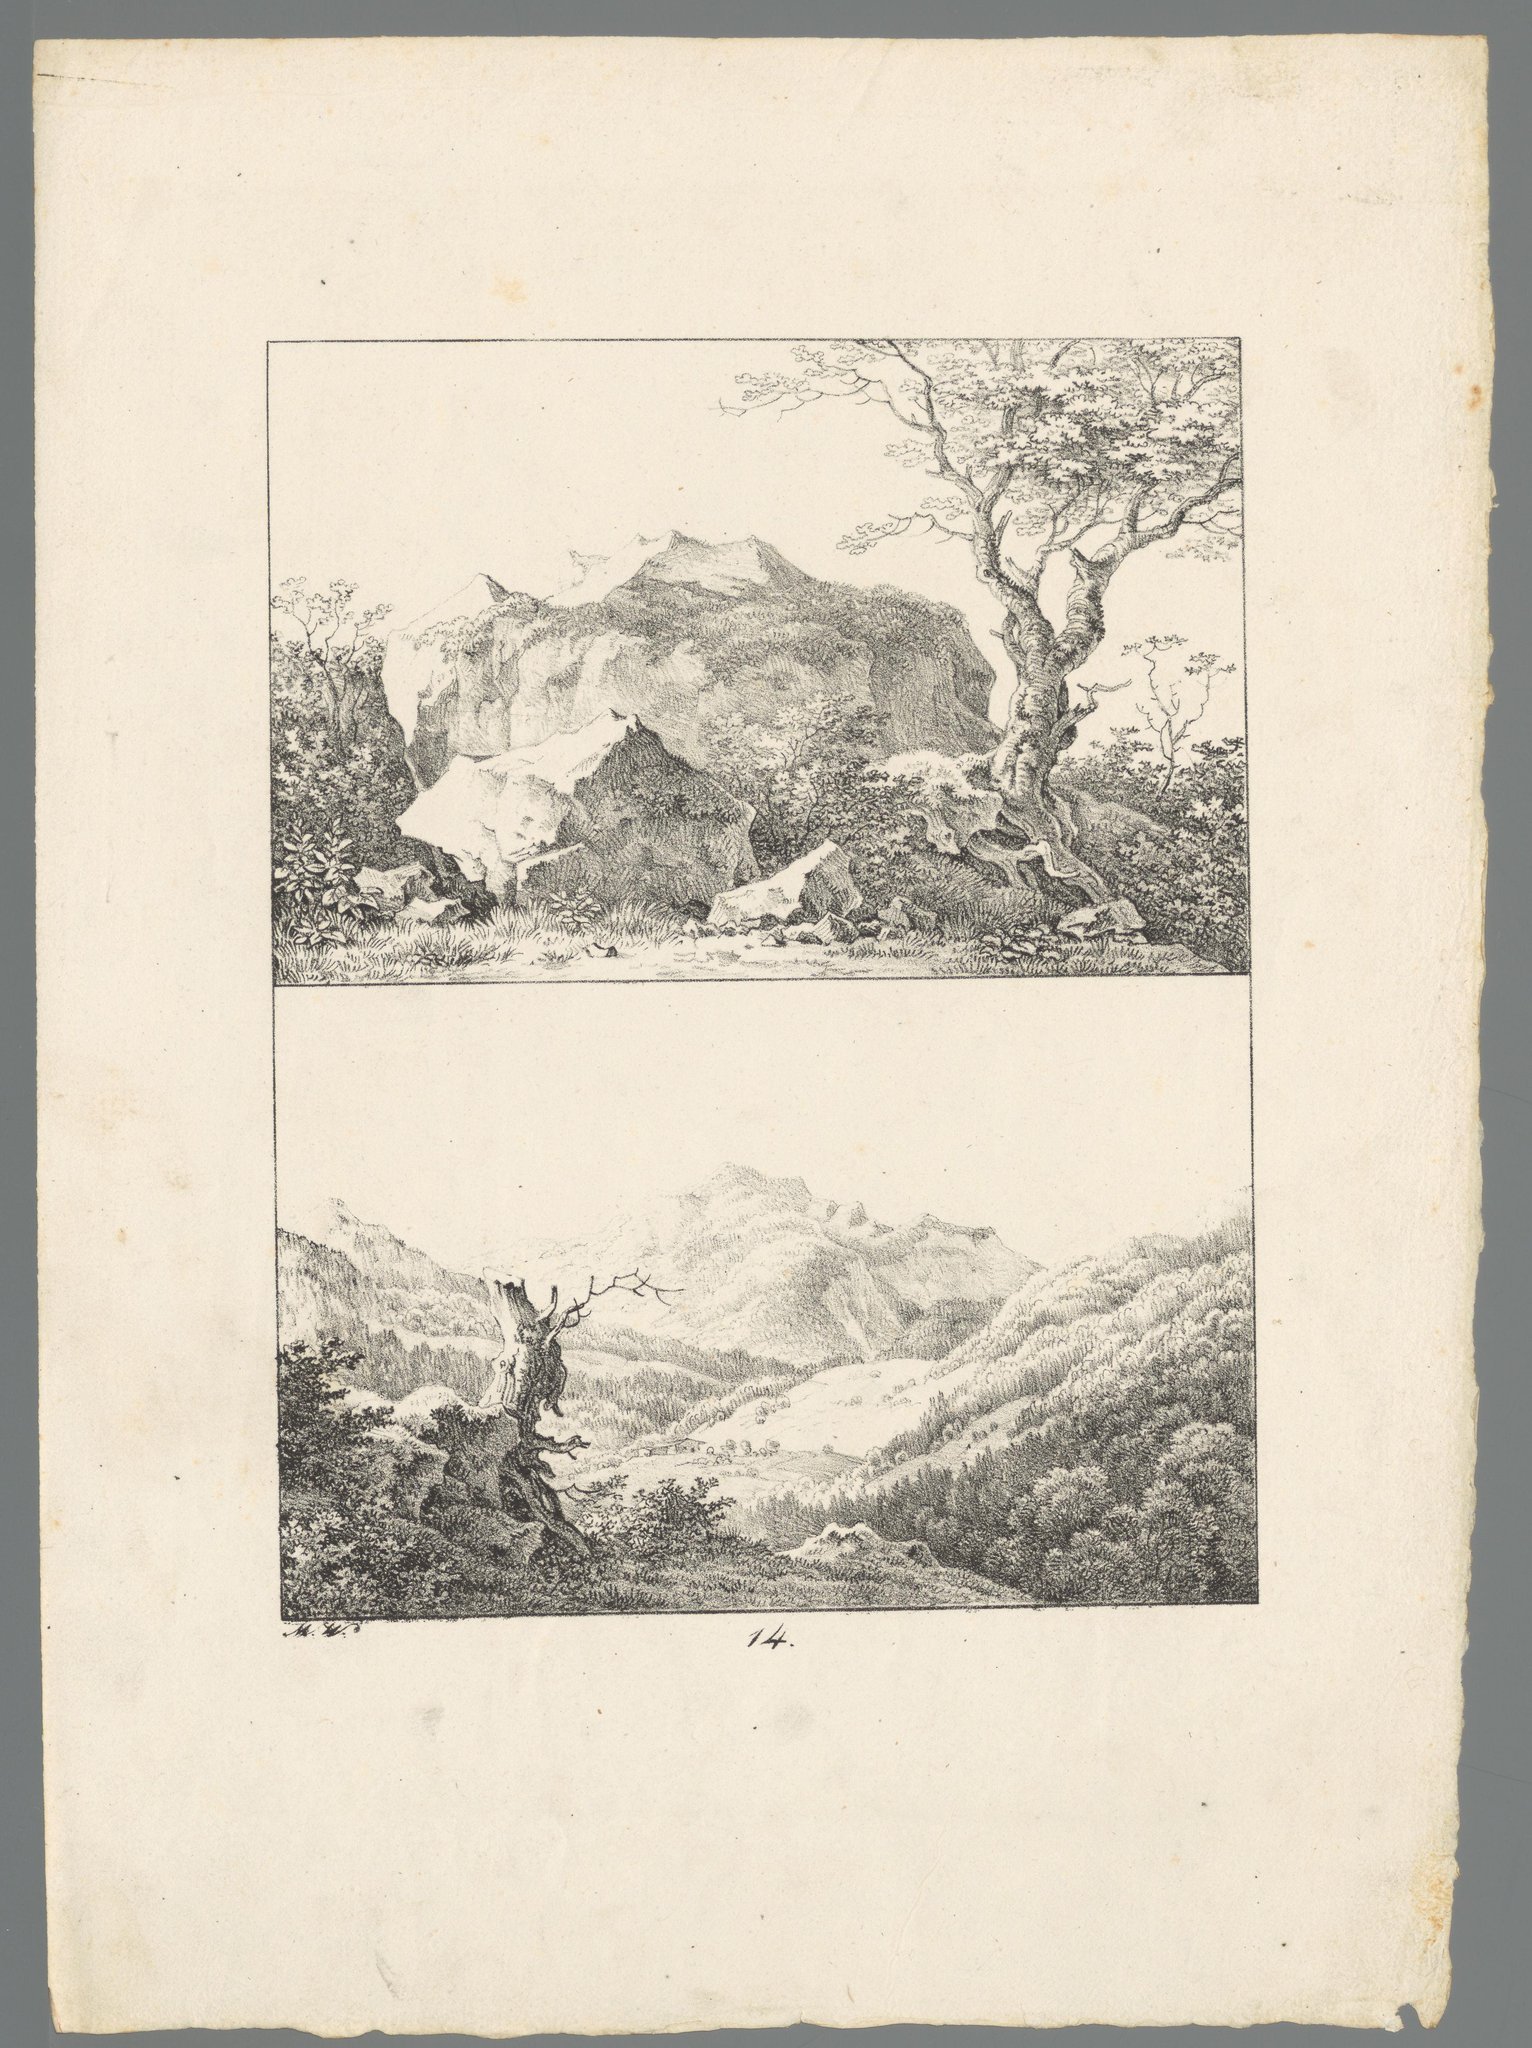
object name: print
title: Vorlagen für Landschaft-zeichner, I Heft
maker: max josef wagenbauer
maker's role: print maker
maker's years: 1774-1829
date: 1823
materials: paper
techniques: lithograph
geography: munich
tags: rocks, mountains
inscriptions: collector's mark: Lugt 2228, collector's mark: Lugt 2760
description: Prent behoort tot het eerste deel van de serie 'Vorlagen für Landschaft-zeichner'. Dit eerste deel bevat twintig prenten.